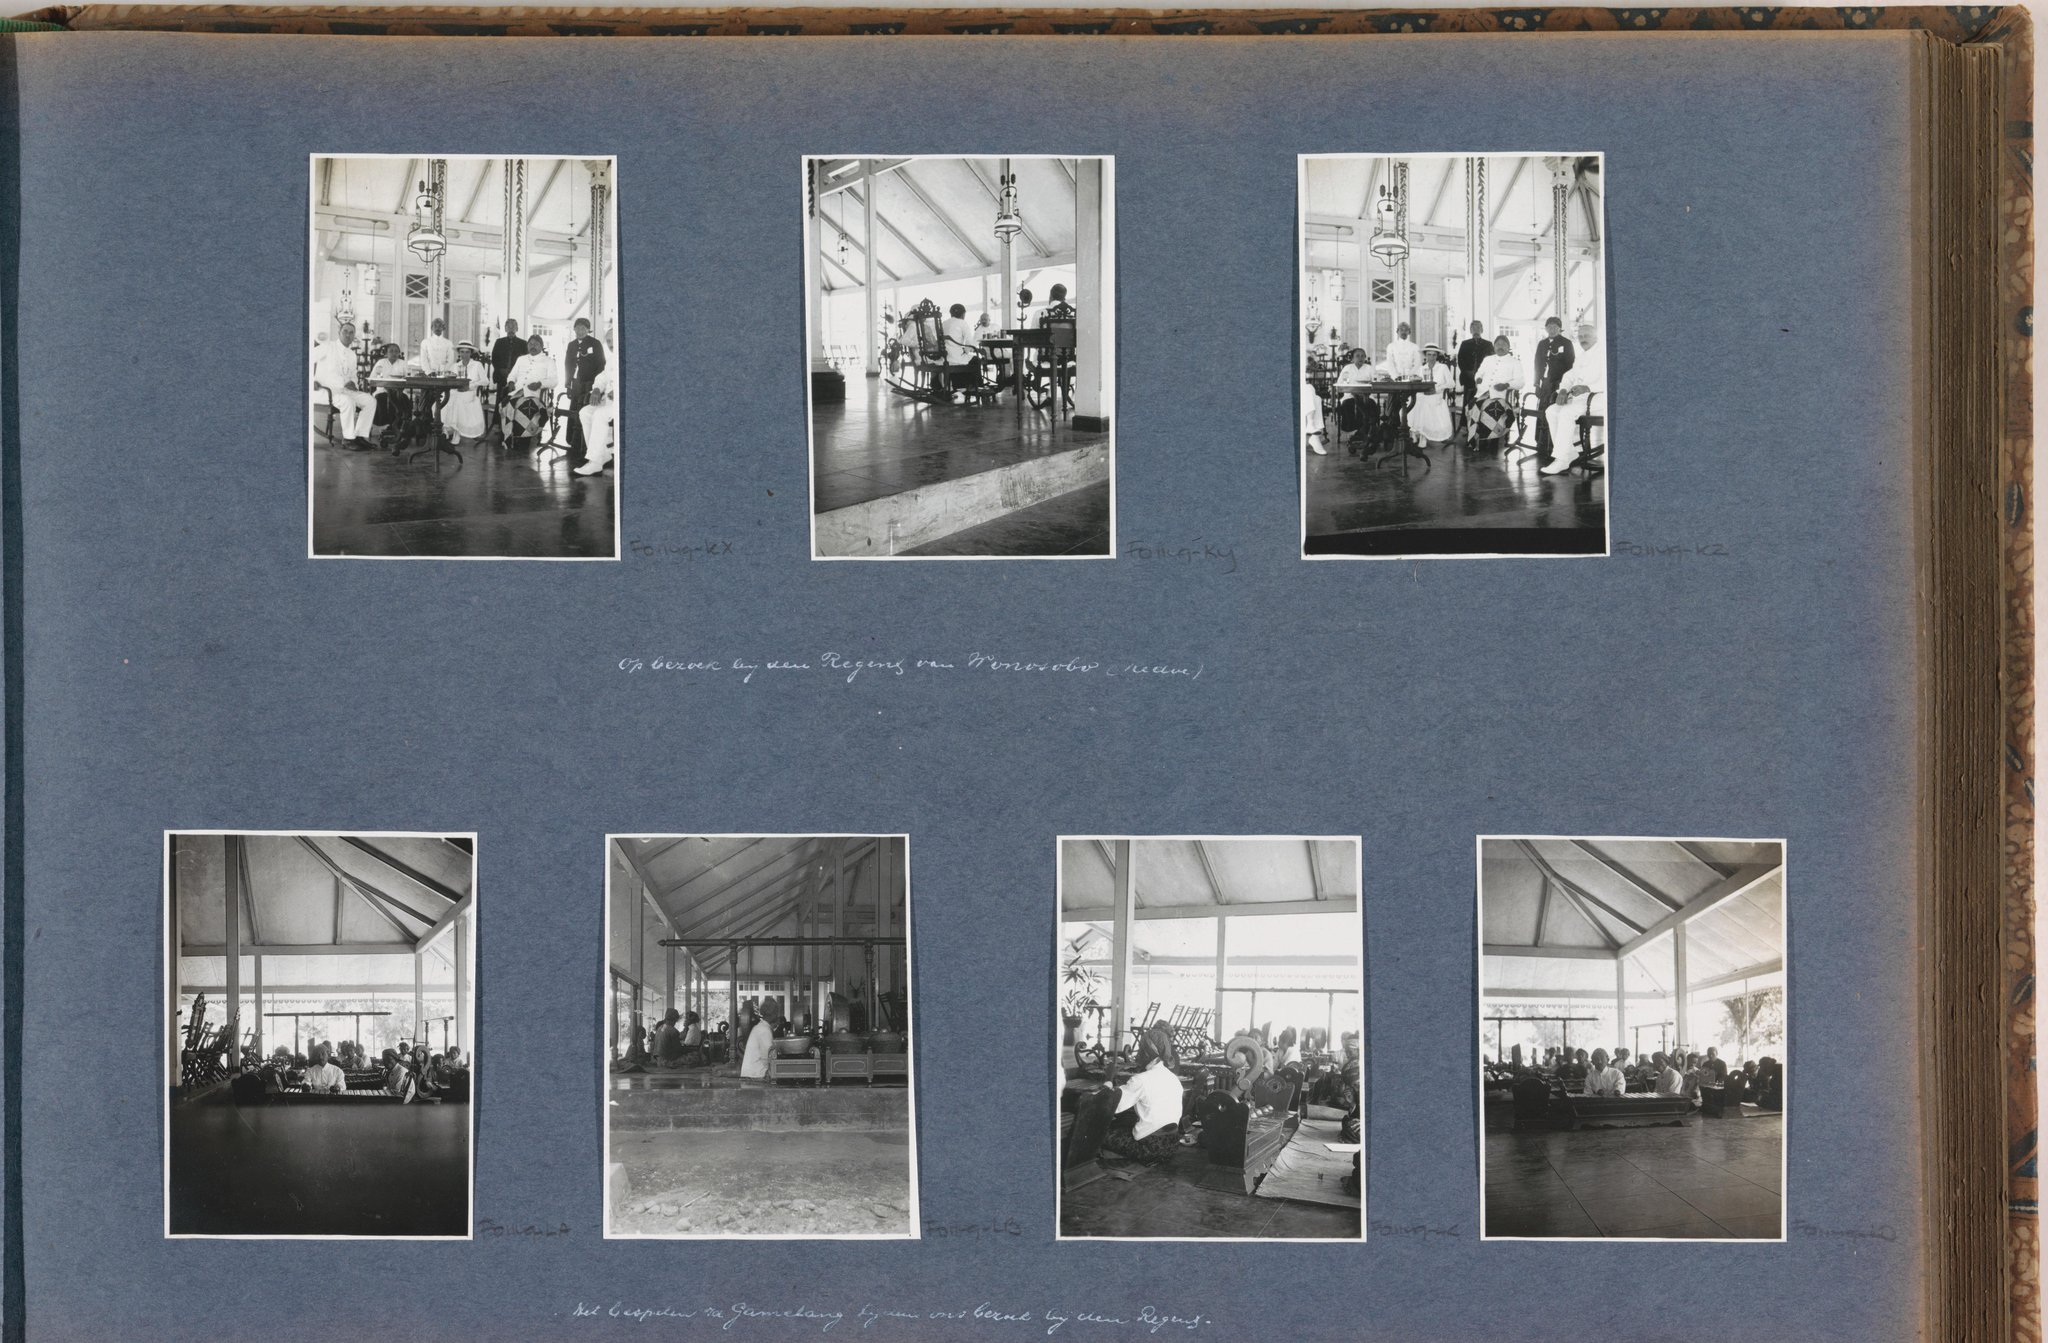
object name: photograph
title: Gamelanorkest spelend tijdens bezoek van Europeanen aan de regent van Wonosobo op Java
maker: Anonymous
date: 1900-1920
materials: paper, photographic support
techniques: gelatin silver print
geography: java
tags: small group of musicians, chamber orchestra, jazz band, interior of the house, java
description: Onderdeel van reisalbum met foto's van bedrijvigheid en bezienswaardigheden op Sumatra en Java en van de reis naar en van Nederlands-Indië.